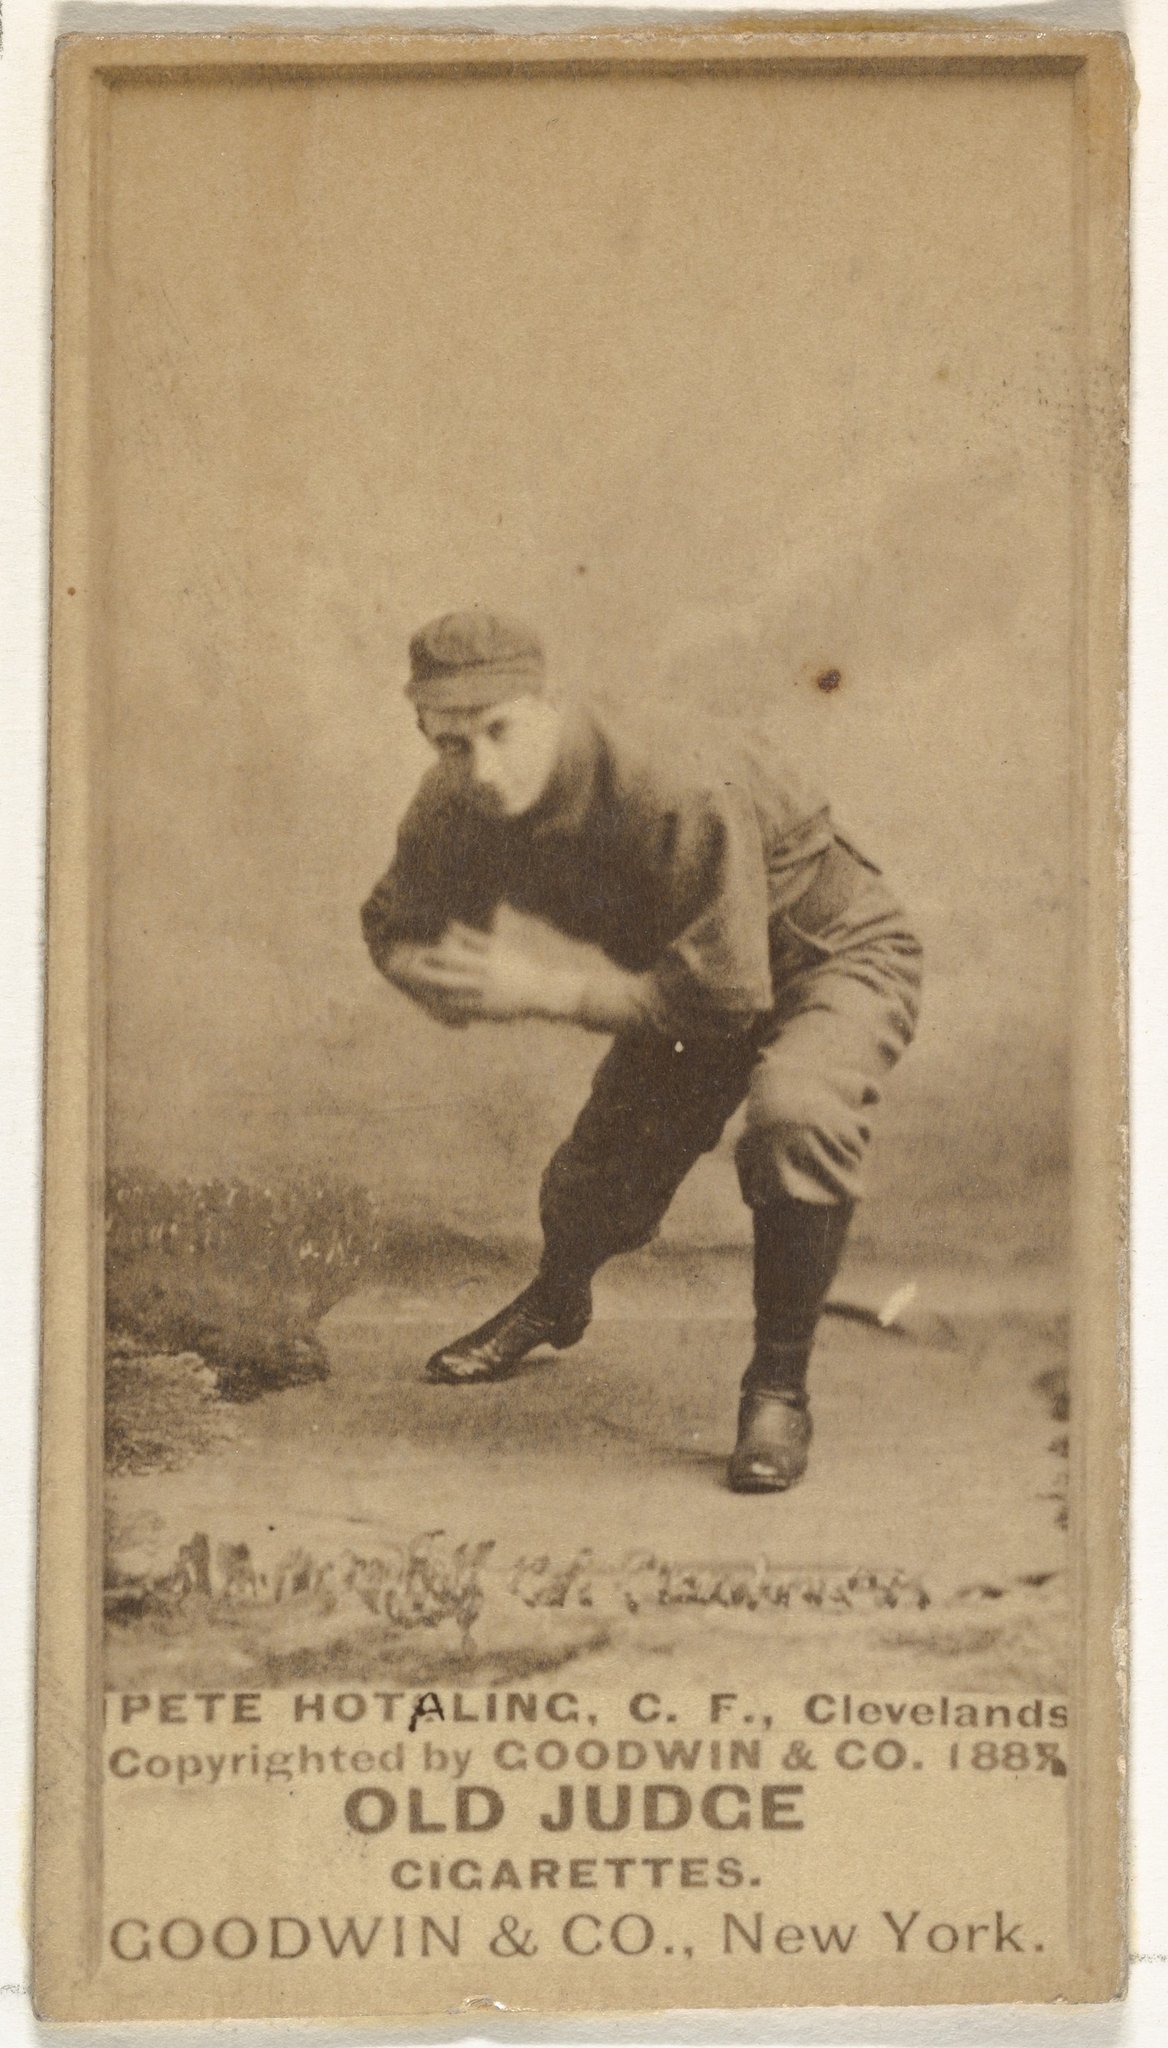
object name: baseball card, photograph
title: Pete "Monkey" Hotaling, Center Field, Cleveland, from the Old Judge series (N172) for Old Judge Cigarettes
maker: goodwin & company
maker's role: publisher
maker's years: 1850-1950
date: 1888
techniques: albumen silver print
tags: men,portraits,baseball,athletes